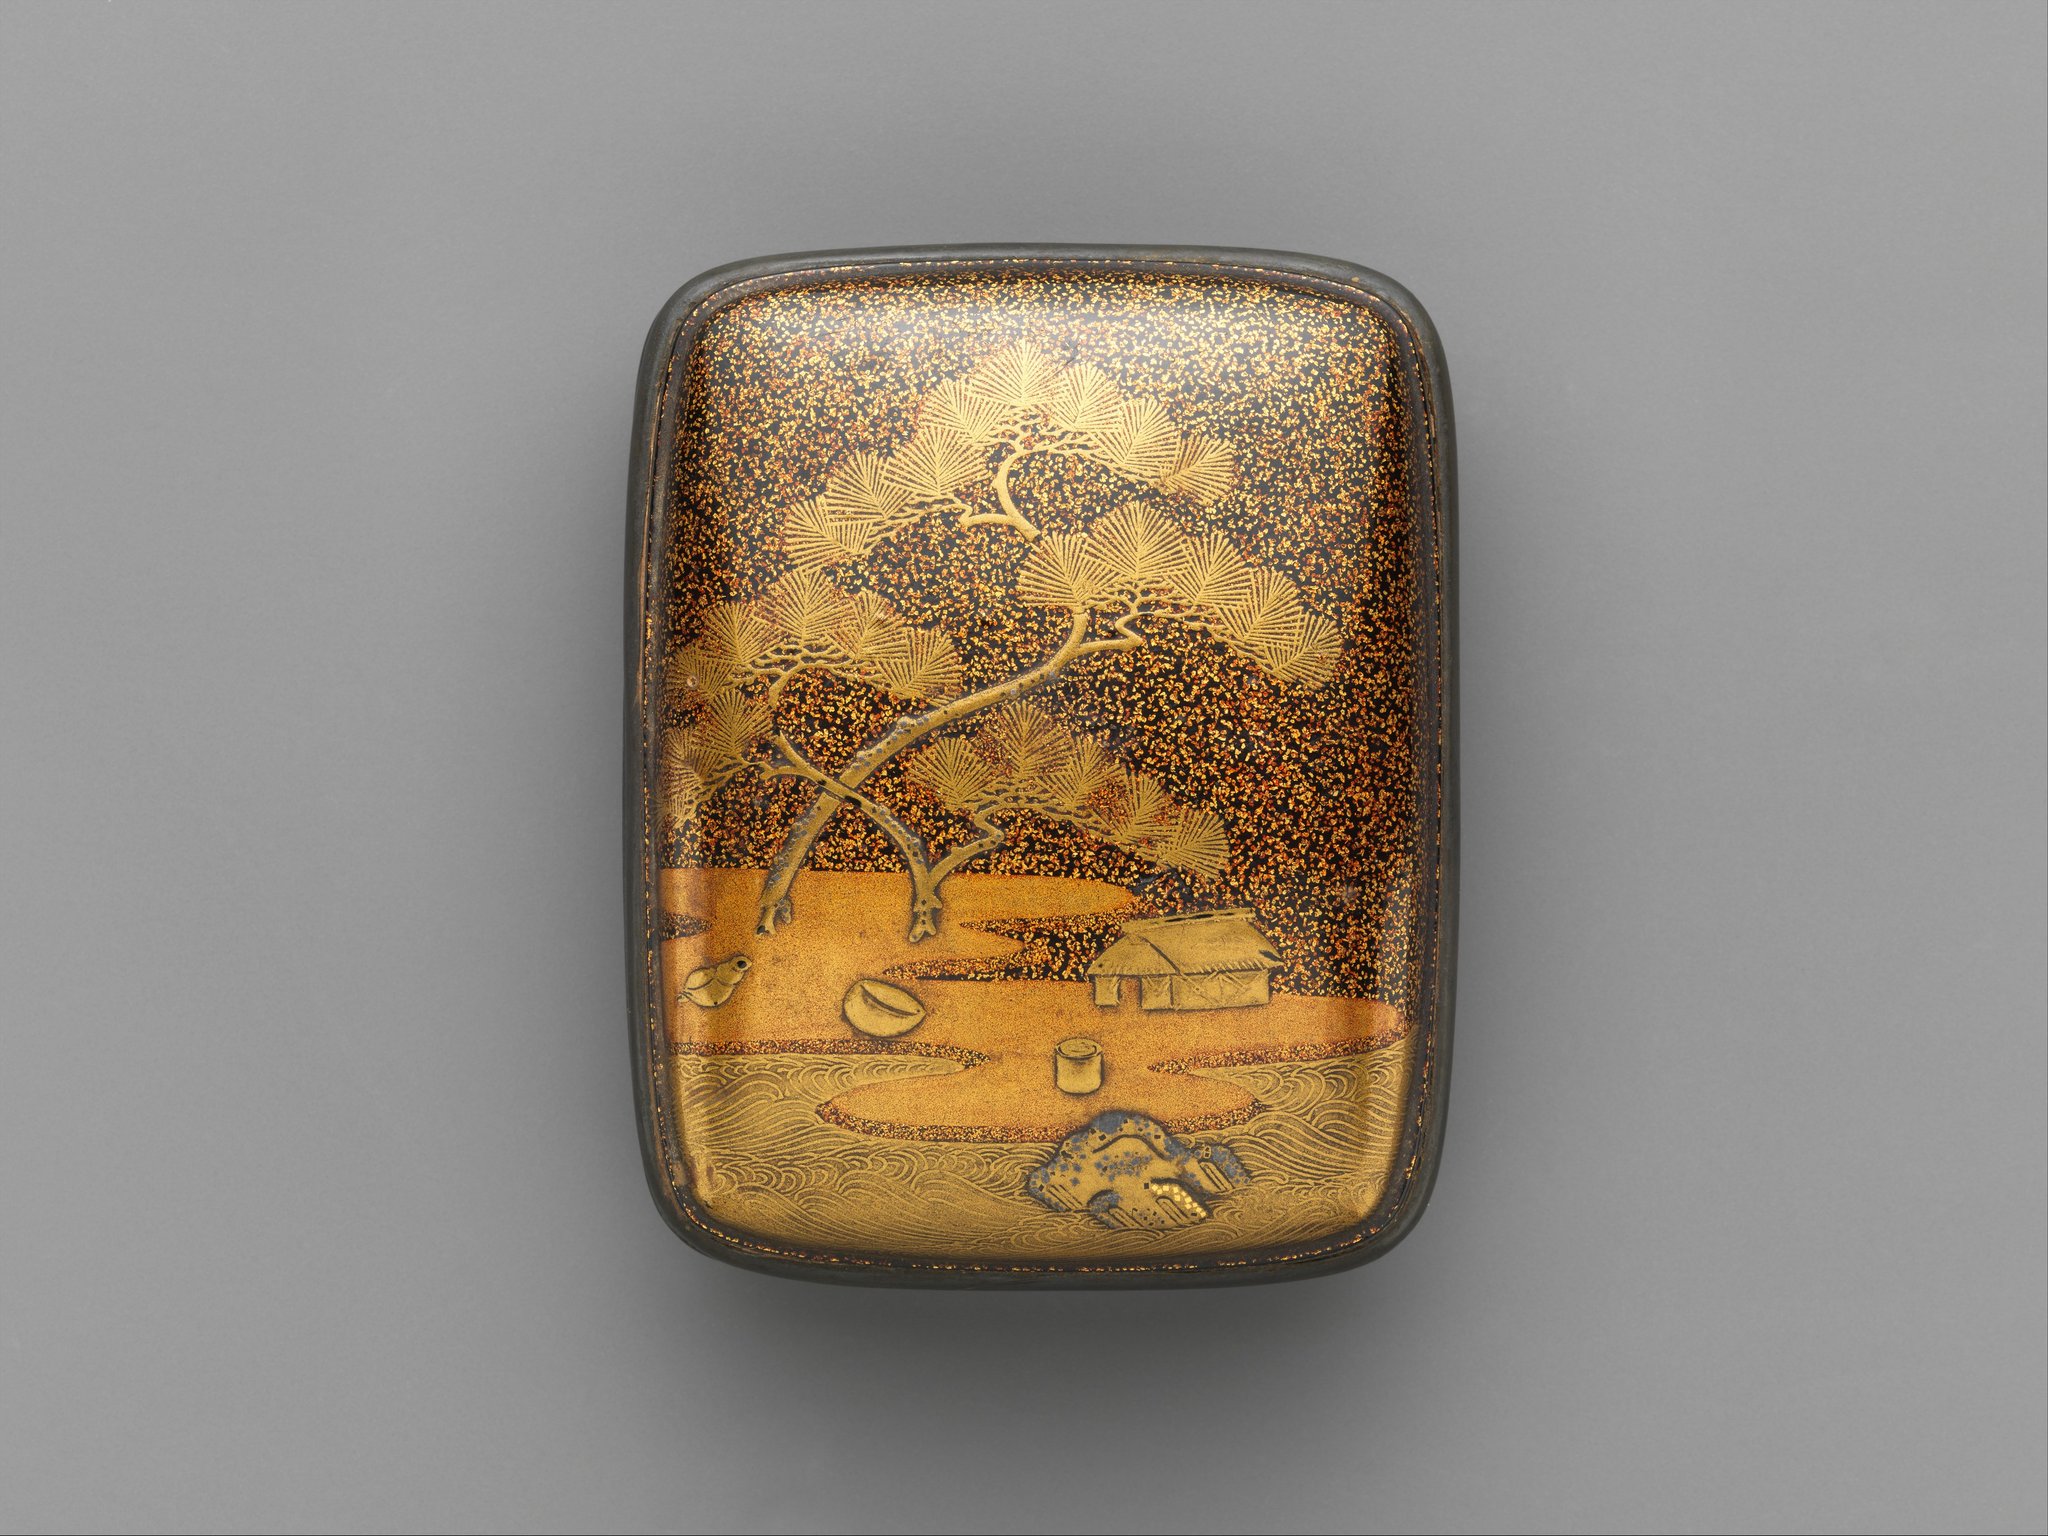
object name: box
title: Box for Tooth Black with Design of Saltmaking Hut on the Shore (Suma no ura)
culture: japanese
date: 1401-1500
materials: gold, lacquer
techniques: maki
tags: houses,trees